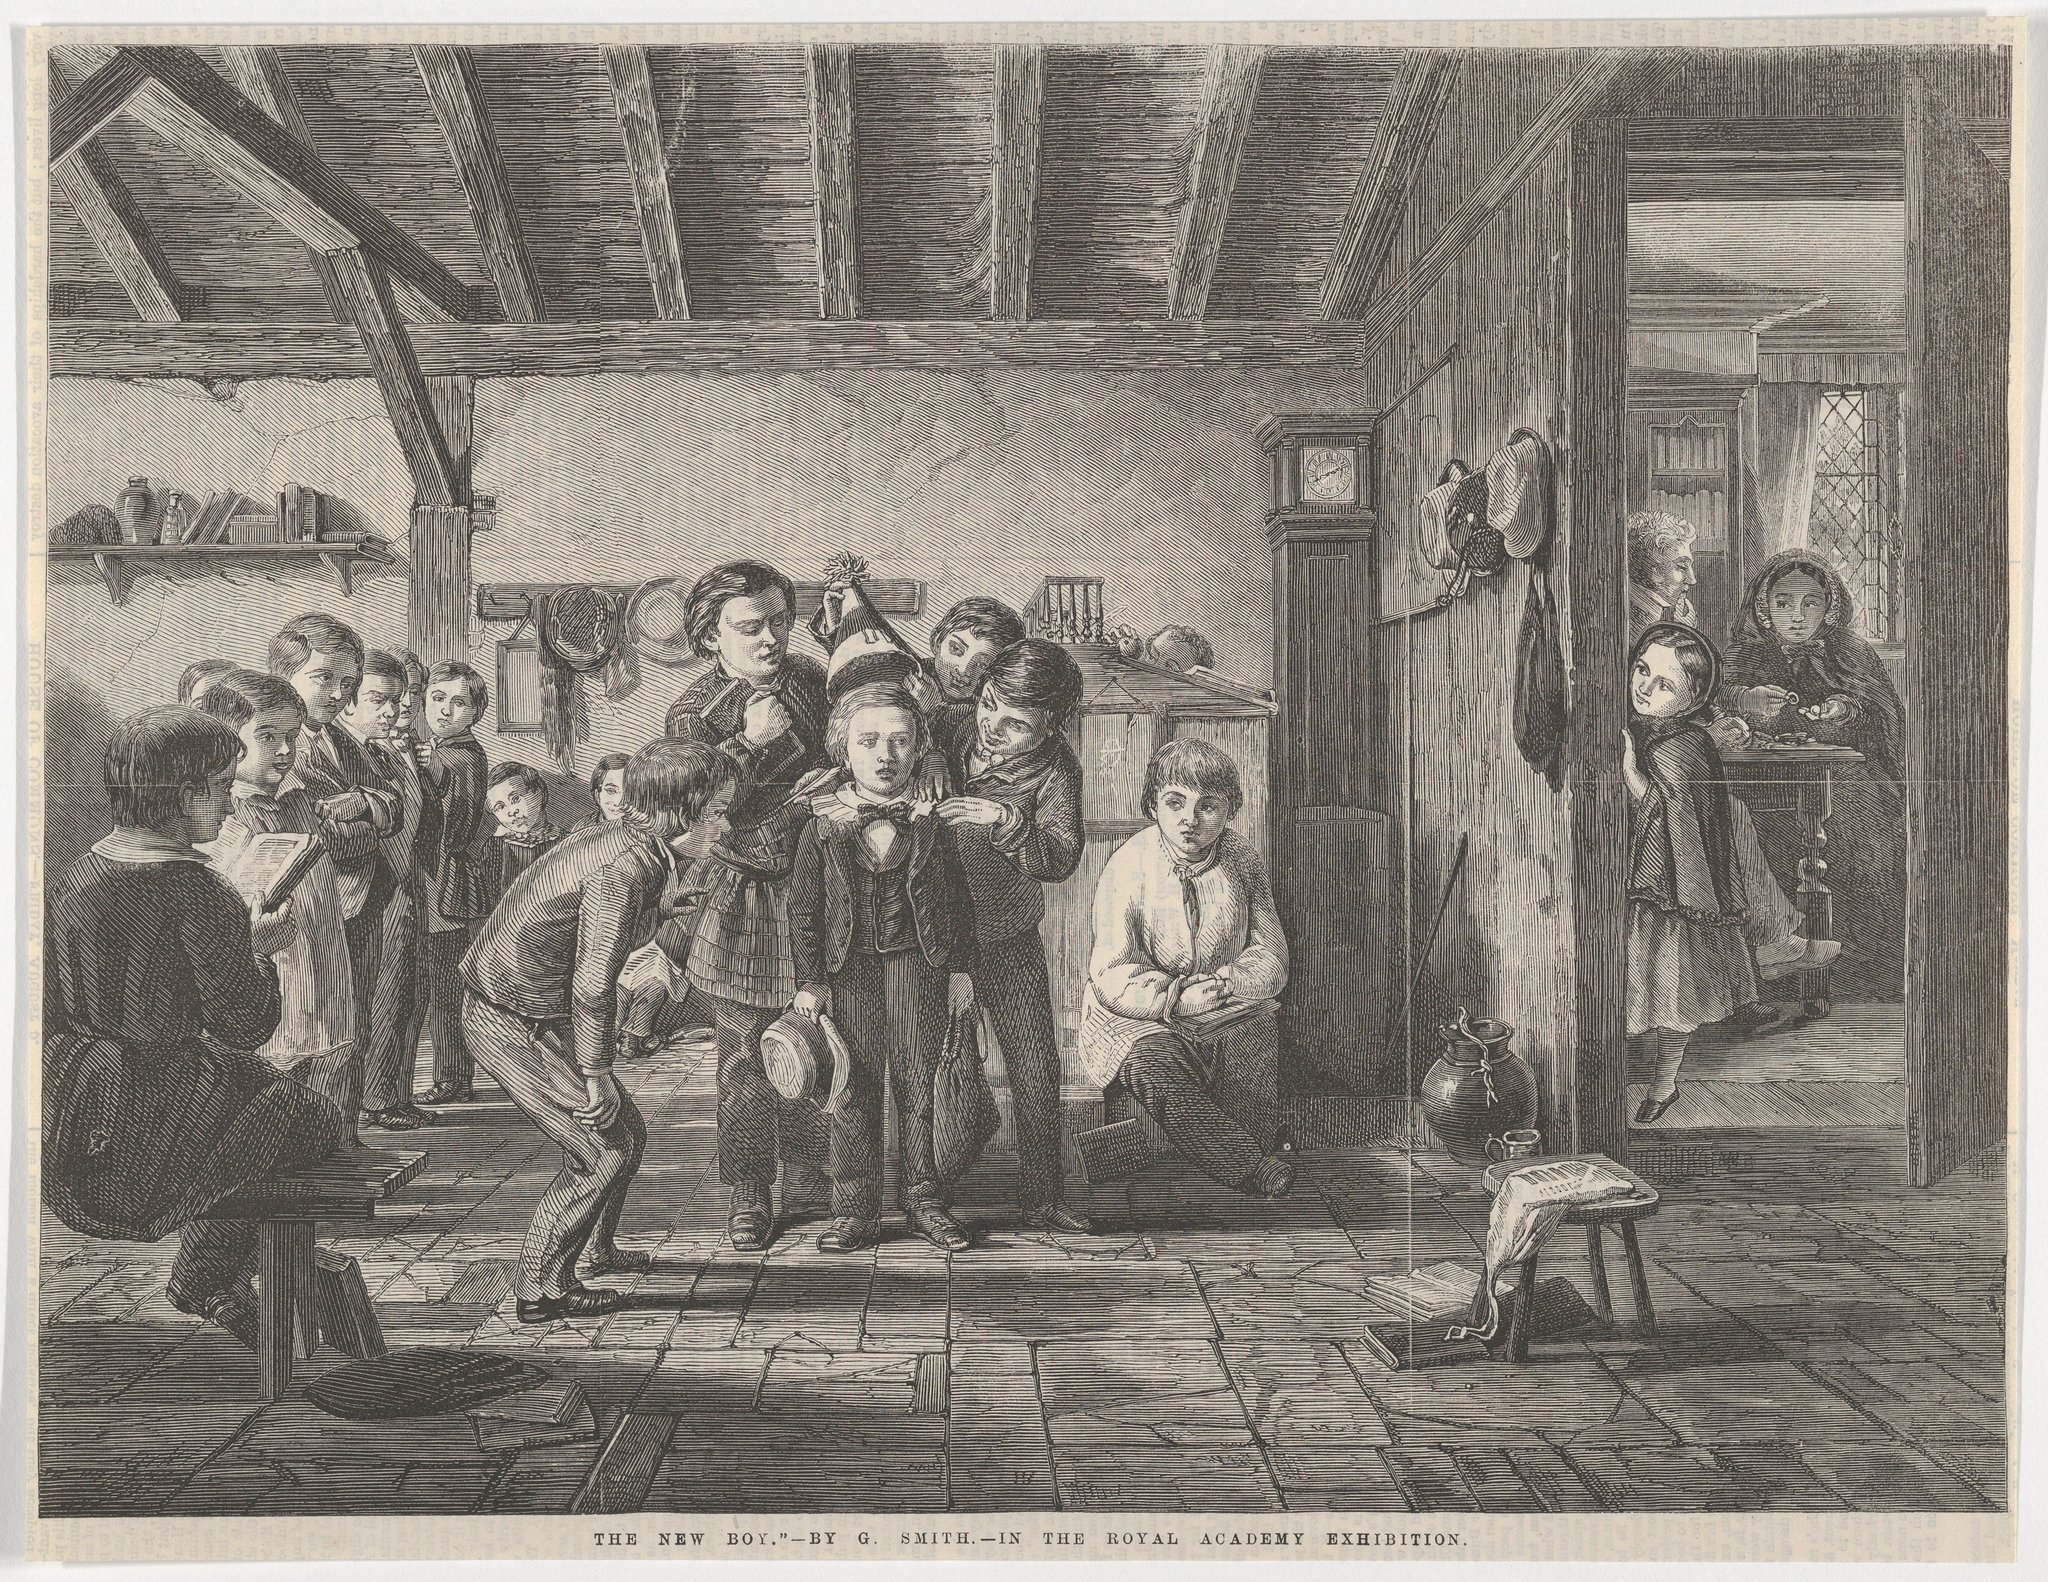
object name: print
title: The New Boy, from "Illustrated London News"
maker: george smith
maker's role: artist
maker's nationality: british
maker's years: 1829-1901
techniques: engraving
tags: boys,girls,women,reading,teachers